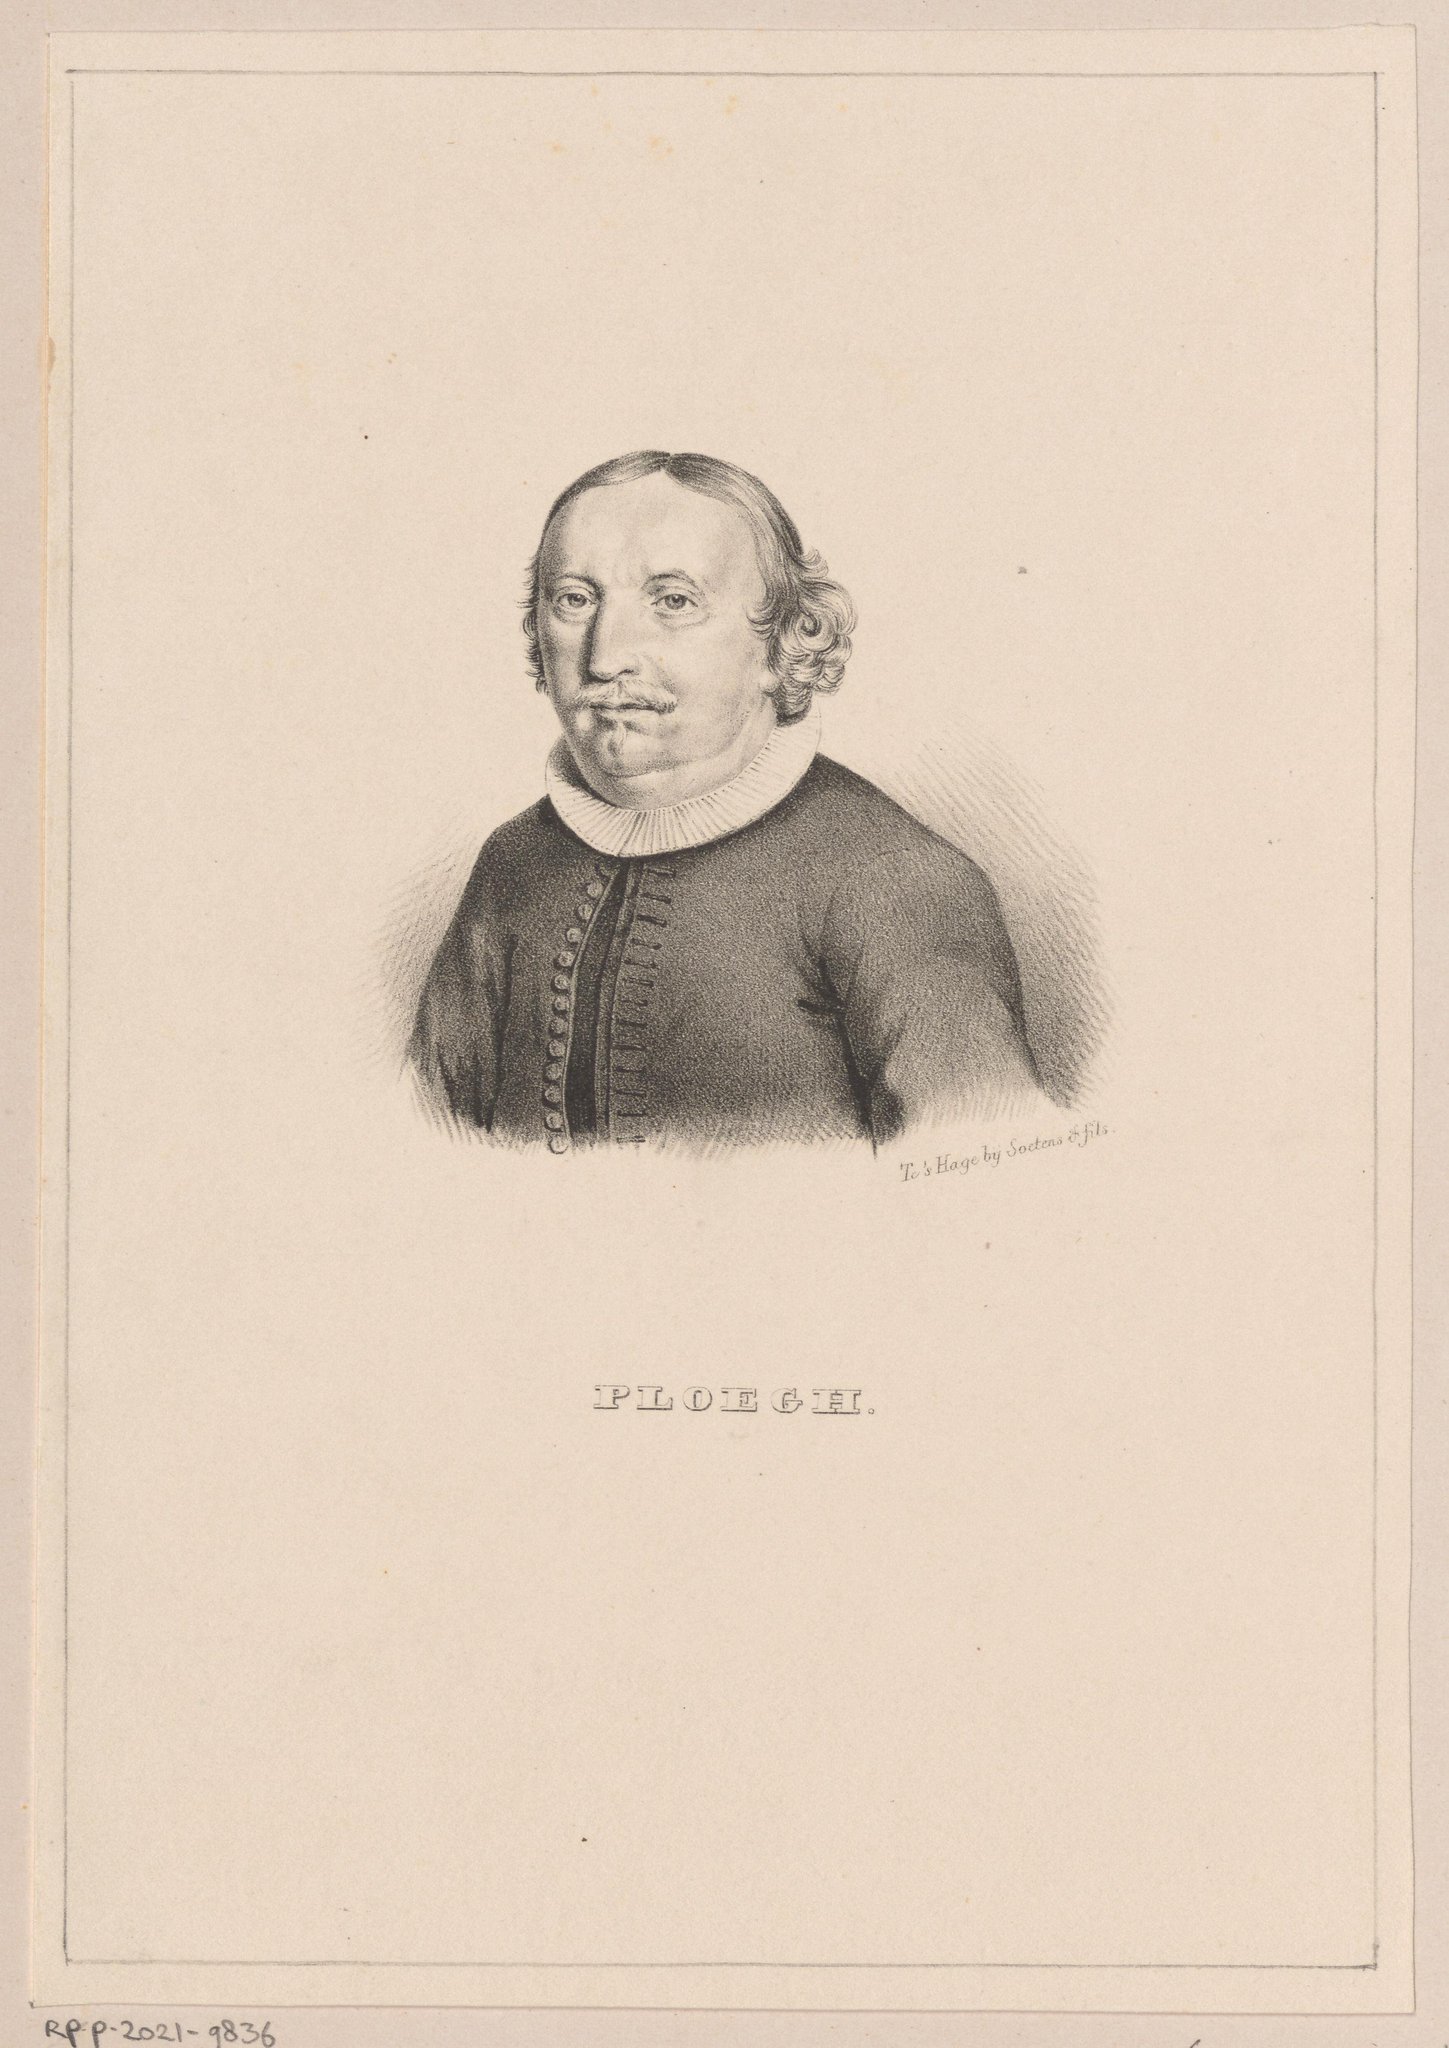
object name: print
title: Portret van Cornelis van den Ploegh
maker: Anonymous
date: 1837-1840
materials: paper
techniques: lithograph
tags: adult man, historical persons, physician, doctor, death's head, skull (symbol of death)